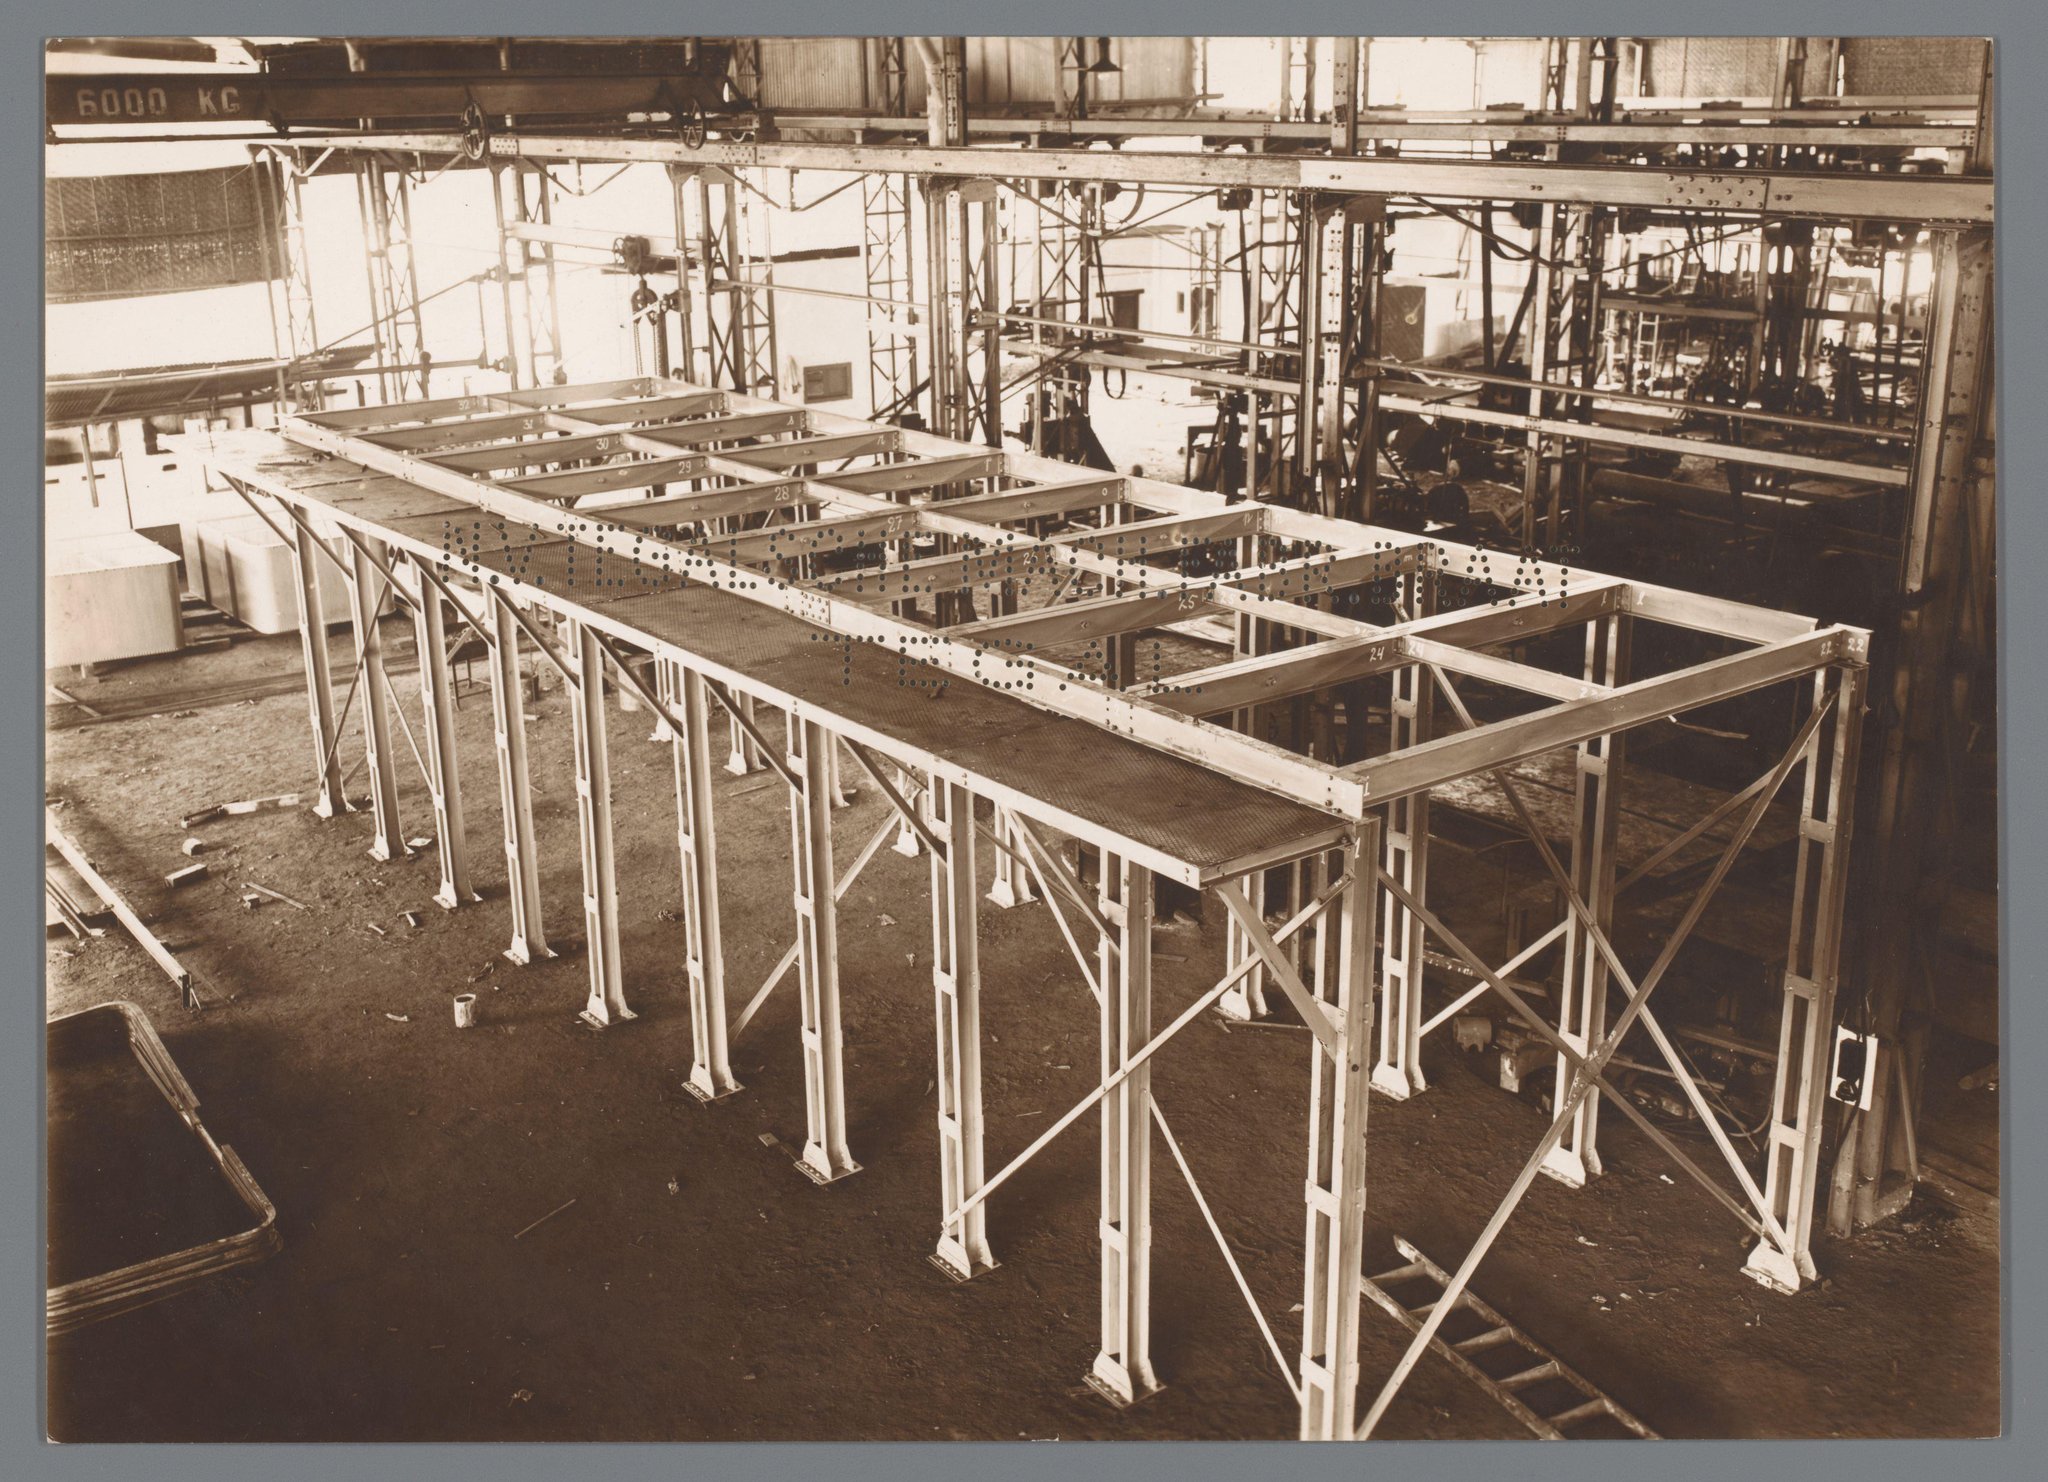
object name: photograph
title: Stroopbordes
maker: Anonymous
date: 1917-1938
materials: photographic support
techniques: gelatin silver print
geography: java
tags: colonial system, factory-interior, machine shop, machines; parts of machines; tools and appliances, (non-fruit) products of plants or trees: sugarcane, java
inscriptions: company name: ‘N.V. Tegalsche Mach. Fabr. Braat / Tegal’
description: Stroopbordes voor negen stroopkisten, van boven gezien, door Tegal geleverd voor een onbekende suikerfabriek. Onderdeel van de multomap met foto's van machines van de N.V. Machinefabriek Braat te Soerabaja bestemd voor de Nederlandse suikerindustrie op Java, uit de periode 1917-1938.